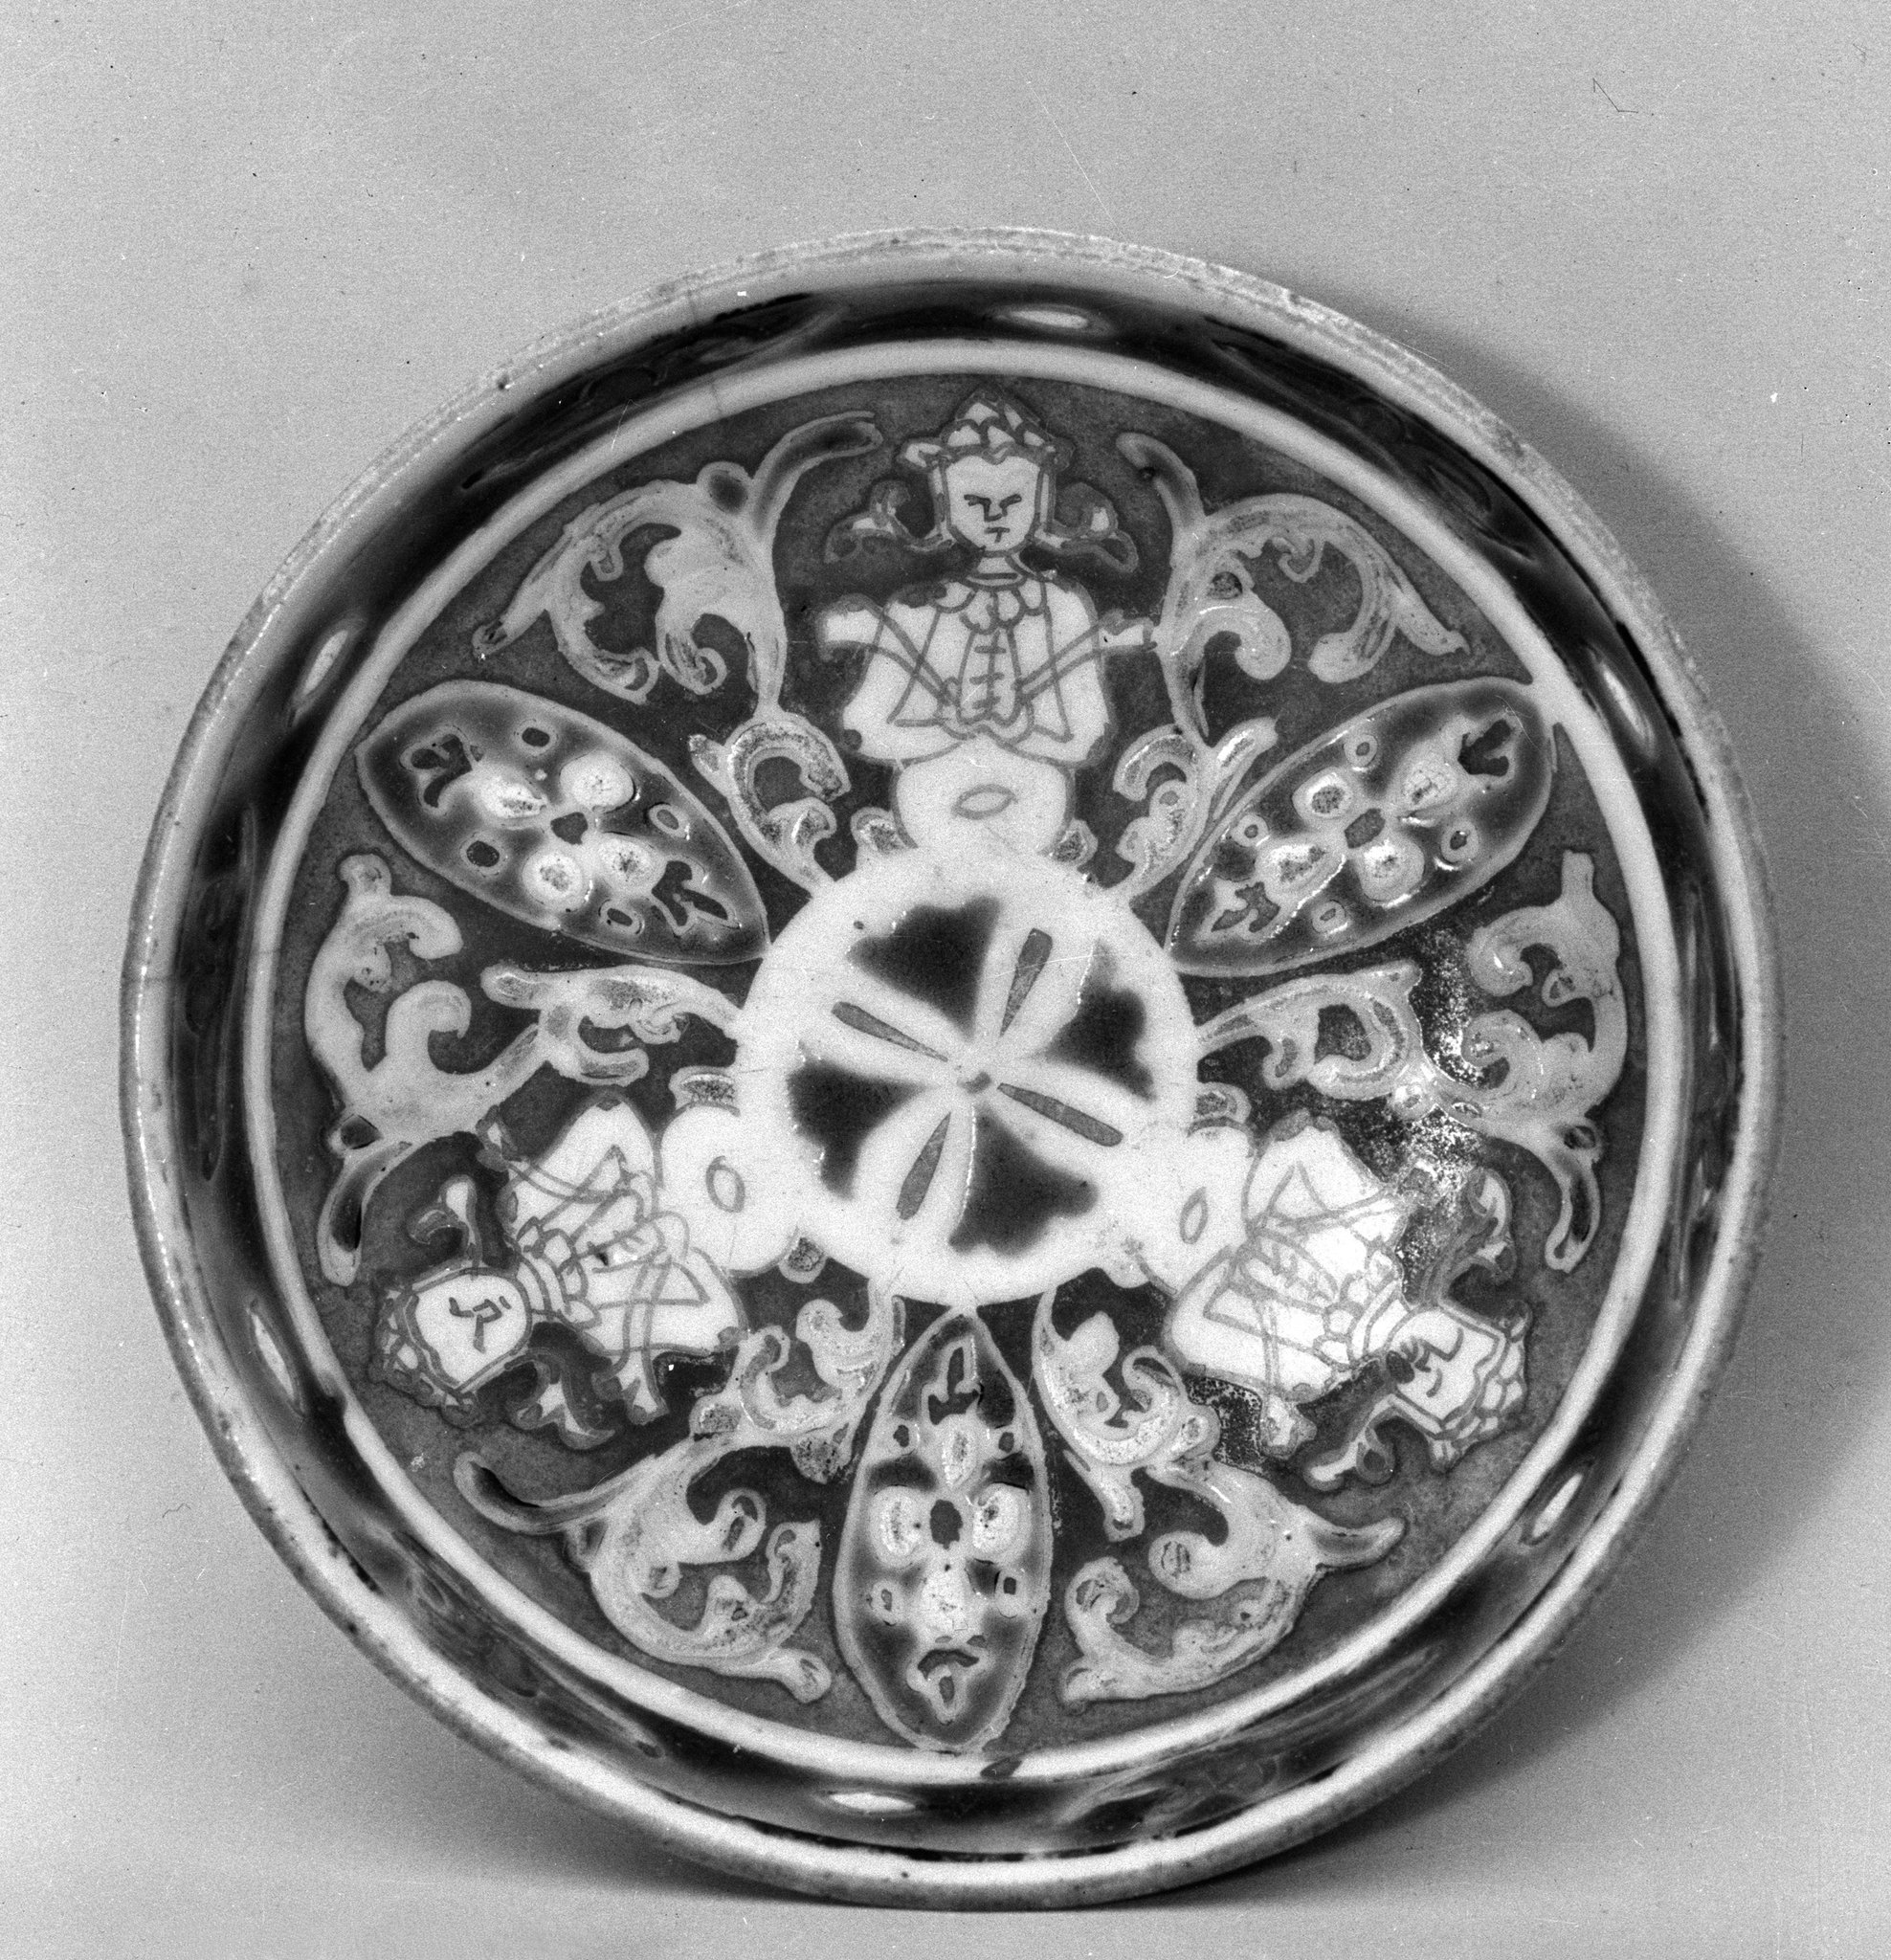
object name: saucer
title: Saucer with Thai mythical figures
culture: chinese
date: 1801-1900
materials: enamel, porcelain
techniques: overglaze, painting, polychrome